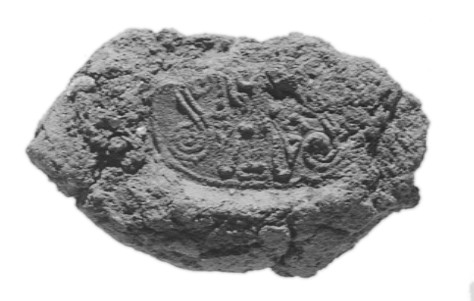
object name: sealing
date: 2030-1640 BCE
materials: clay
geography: egypt